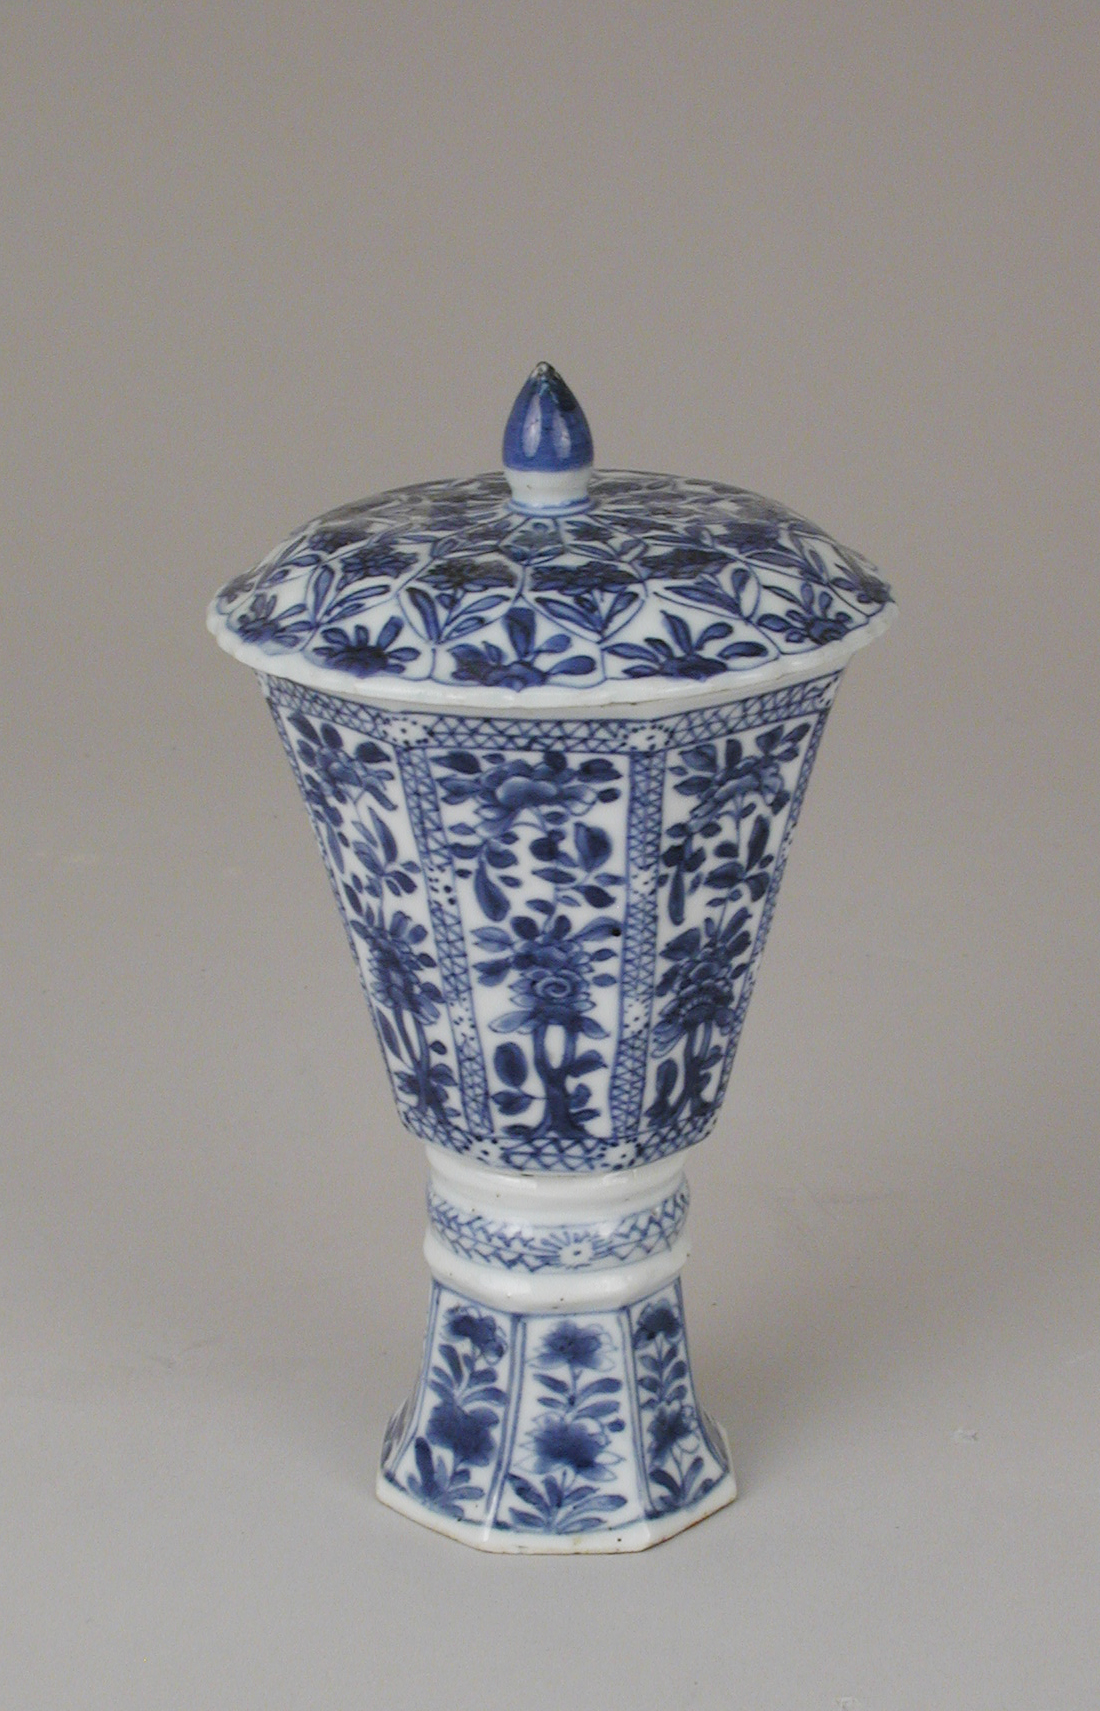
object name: cup with cover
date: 1690-1700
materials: hard paste porcelain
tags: flowers